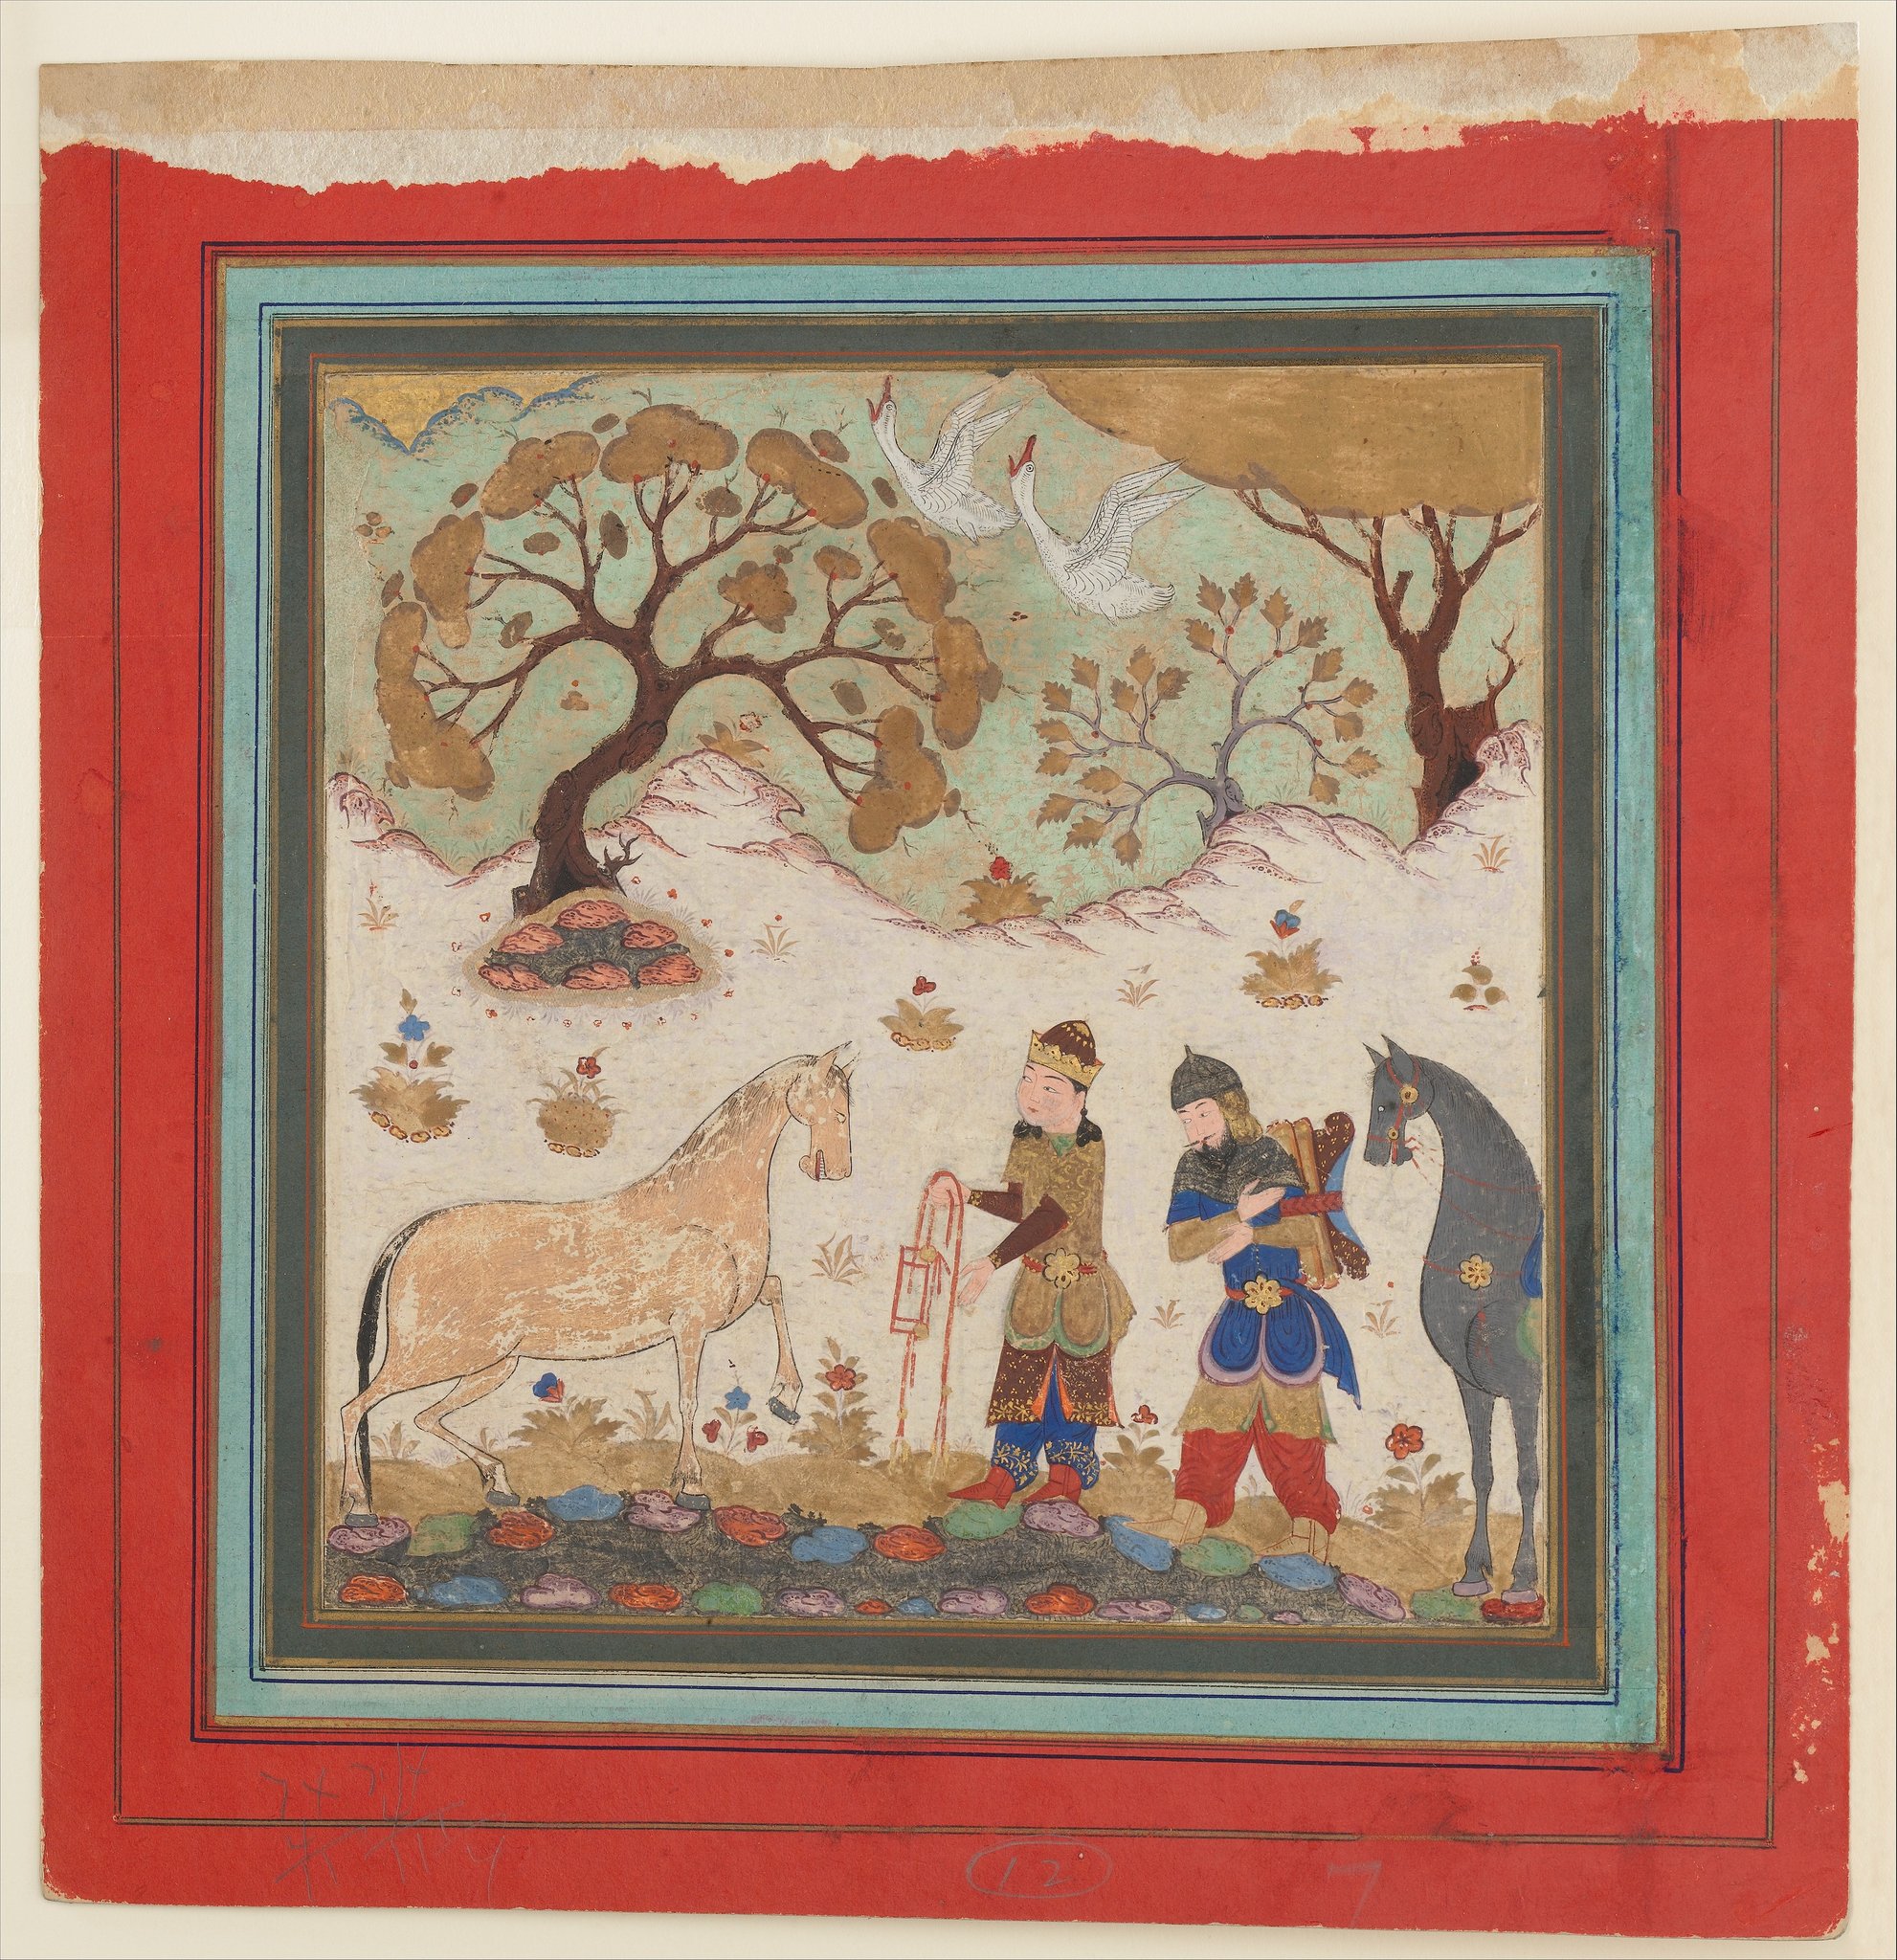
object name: folio from an illustrated manuscript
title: "Rustam Captures Rakhsh", Folio from a Shahnama (Book of Kings)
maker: abu'l qasim firdausi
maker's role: author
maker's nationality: iranian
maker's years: 935-1020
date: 1434-1466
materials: gold, ink, paper, watercolor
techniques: dyeing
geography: india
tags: birds,men,horses,trees